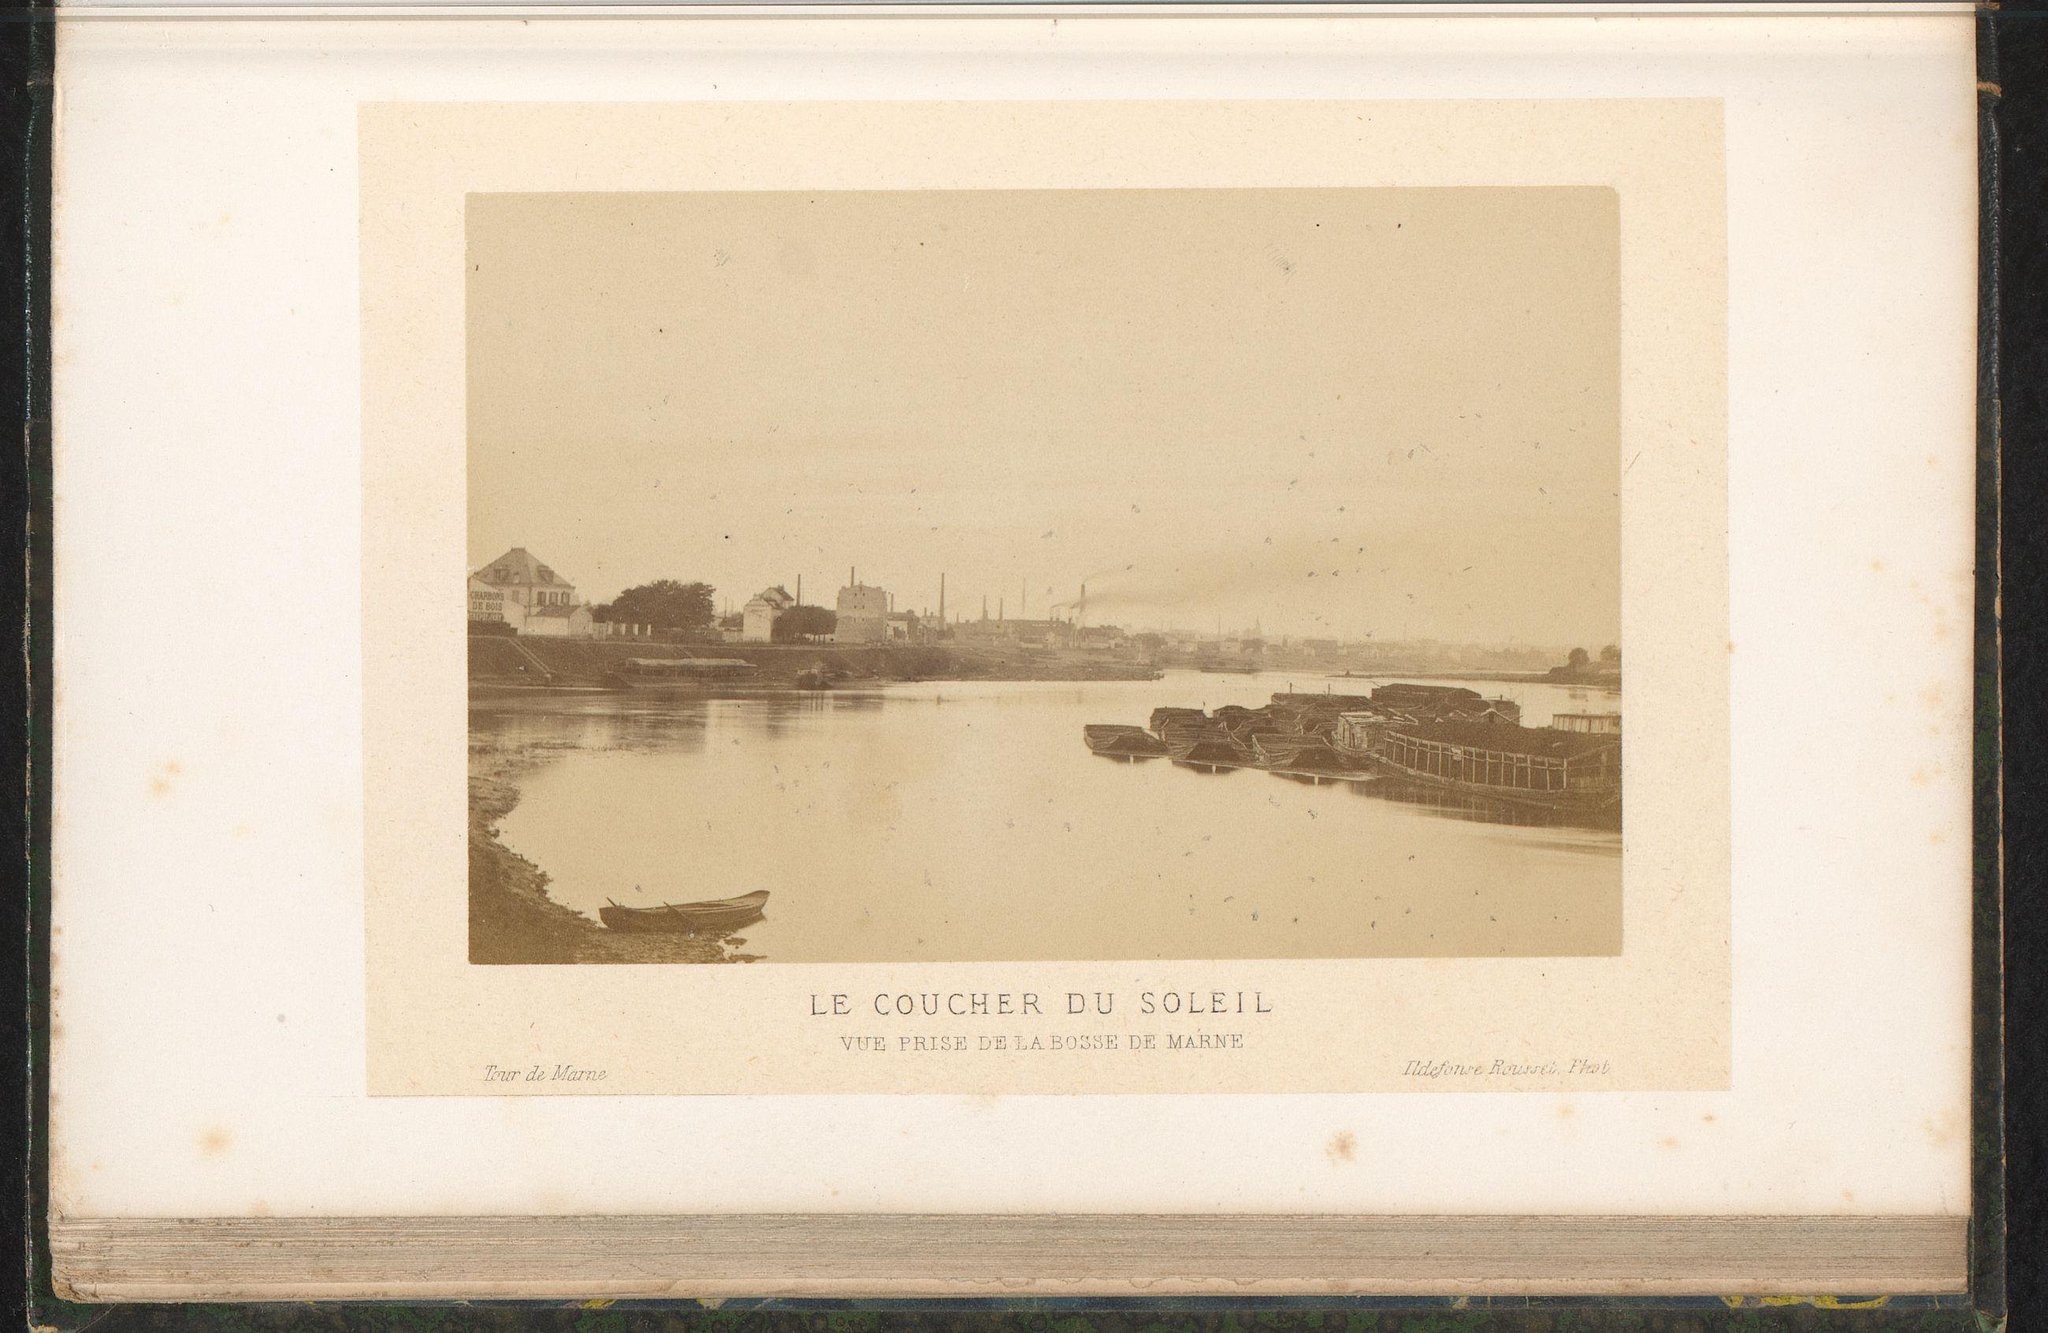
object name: page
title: Zonsondergang over de Marne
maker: ildefonse rousset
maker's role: fotograaf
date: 1860-1865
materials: paper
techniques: albumen print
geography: marne river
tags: river, sunset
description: Foto op ongenummerde pagina tegenover pagina 128.